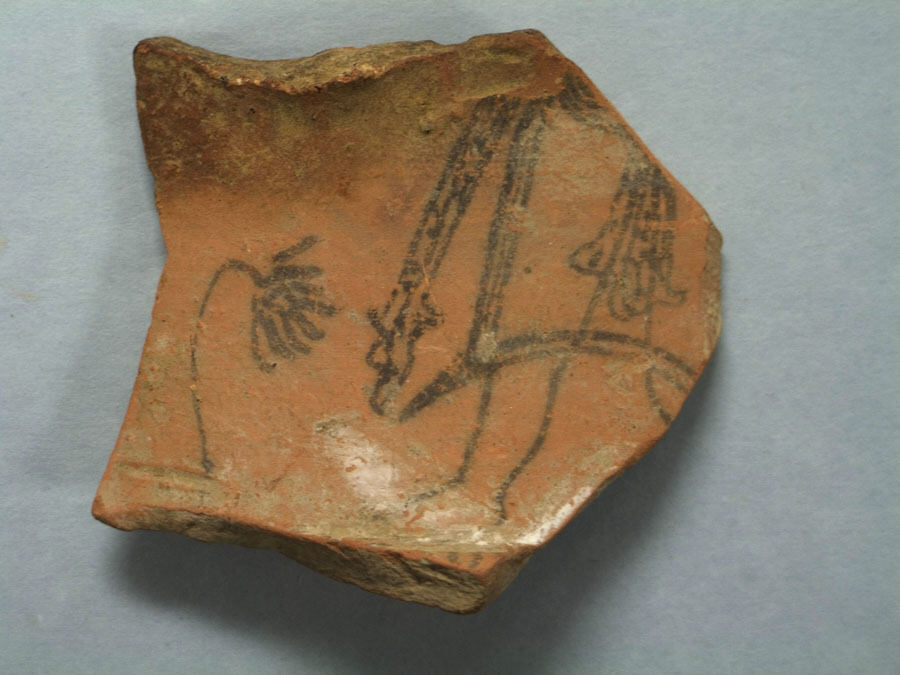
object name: shard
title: Shard: Lower Part of Torso with Kushan Dress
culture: pakistani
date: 301-500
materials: terracotta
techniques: painting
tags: gandhara